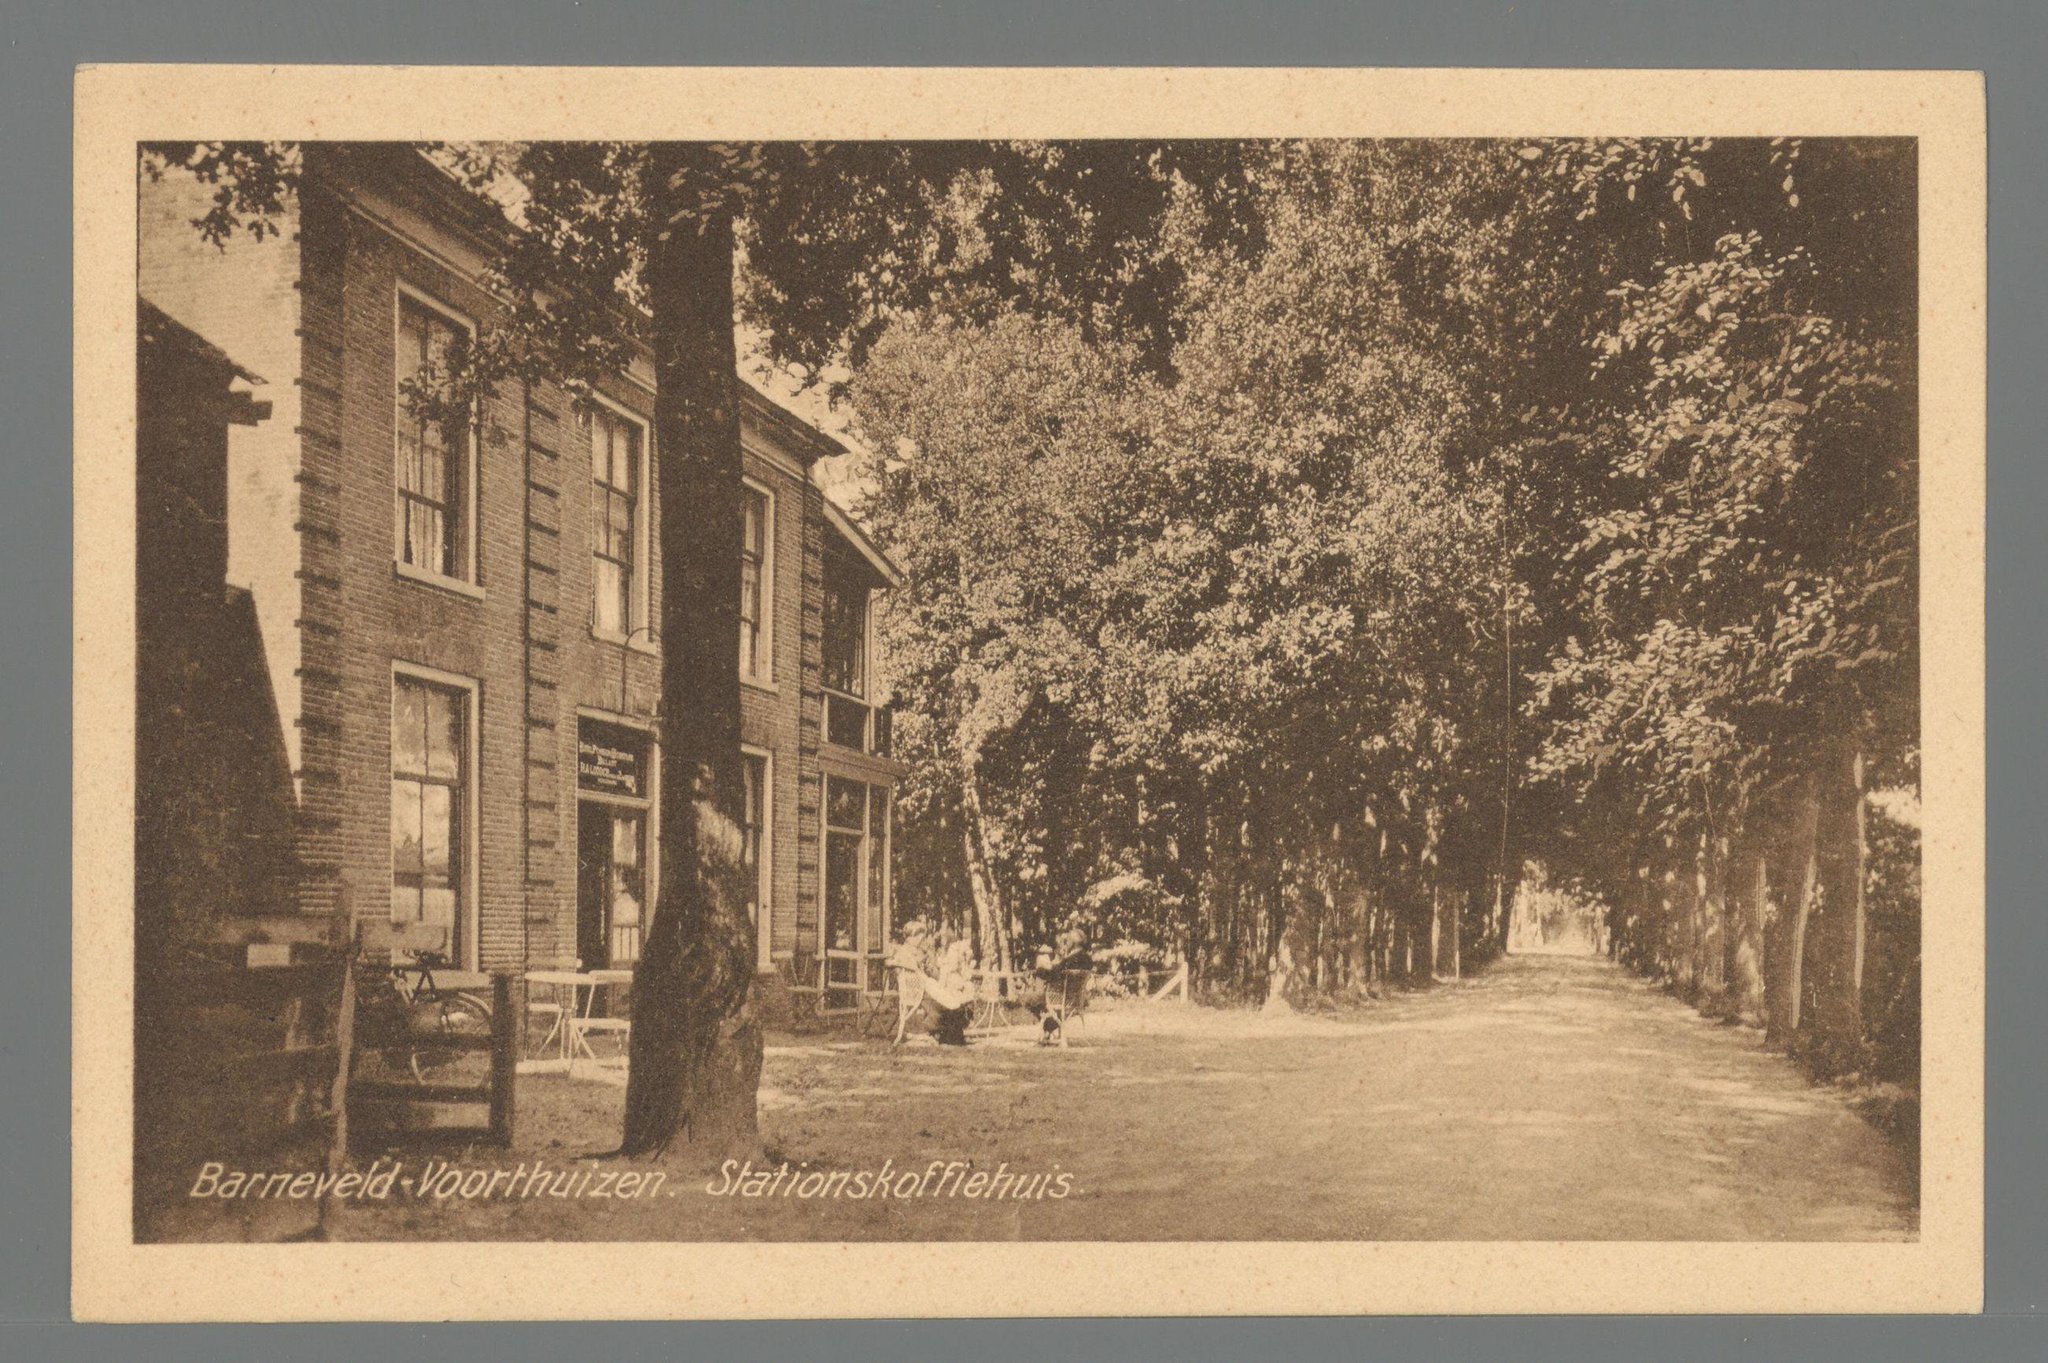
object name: photomechanical print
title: Barneveld-Voorthuizen. Stationskoffiehuis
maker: Anonymous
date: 1922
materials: cardboard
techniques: photograph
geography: barneveld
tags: inn, coffee-house, public house, etc., street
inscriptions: date